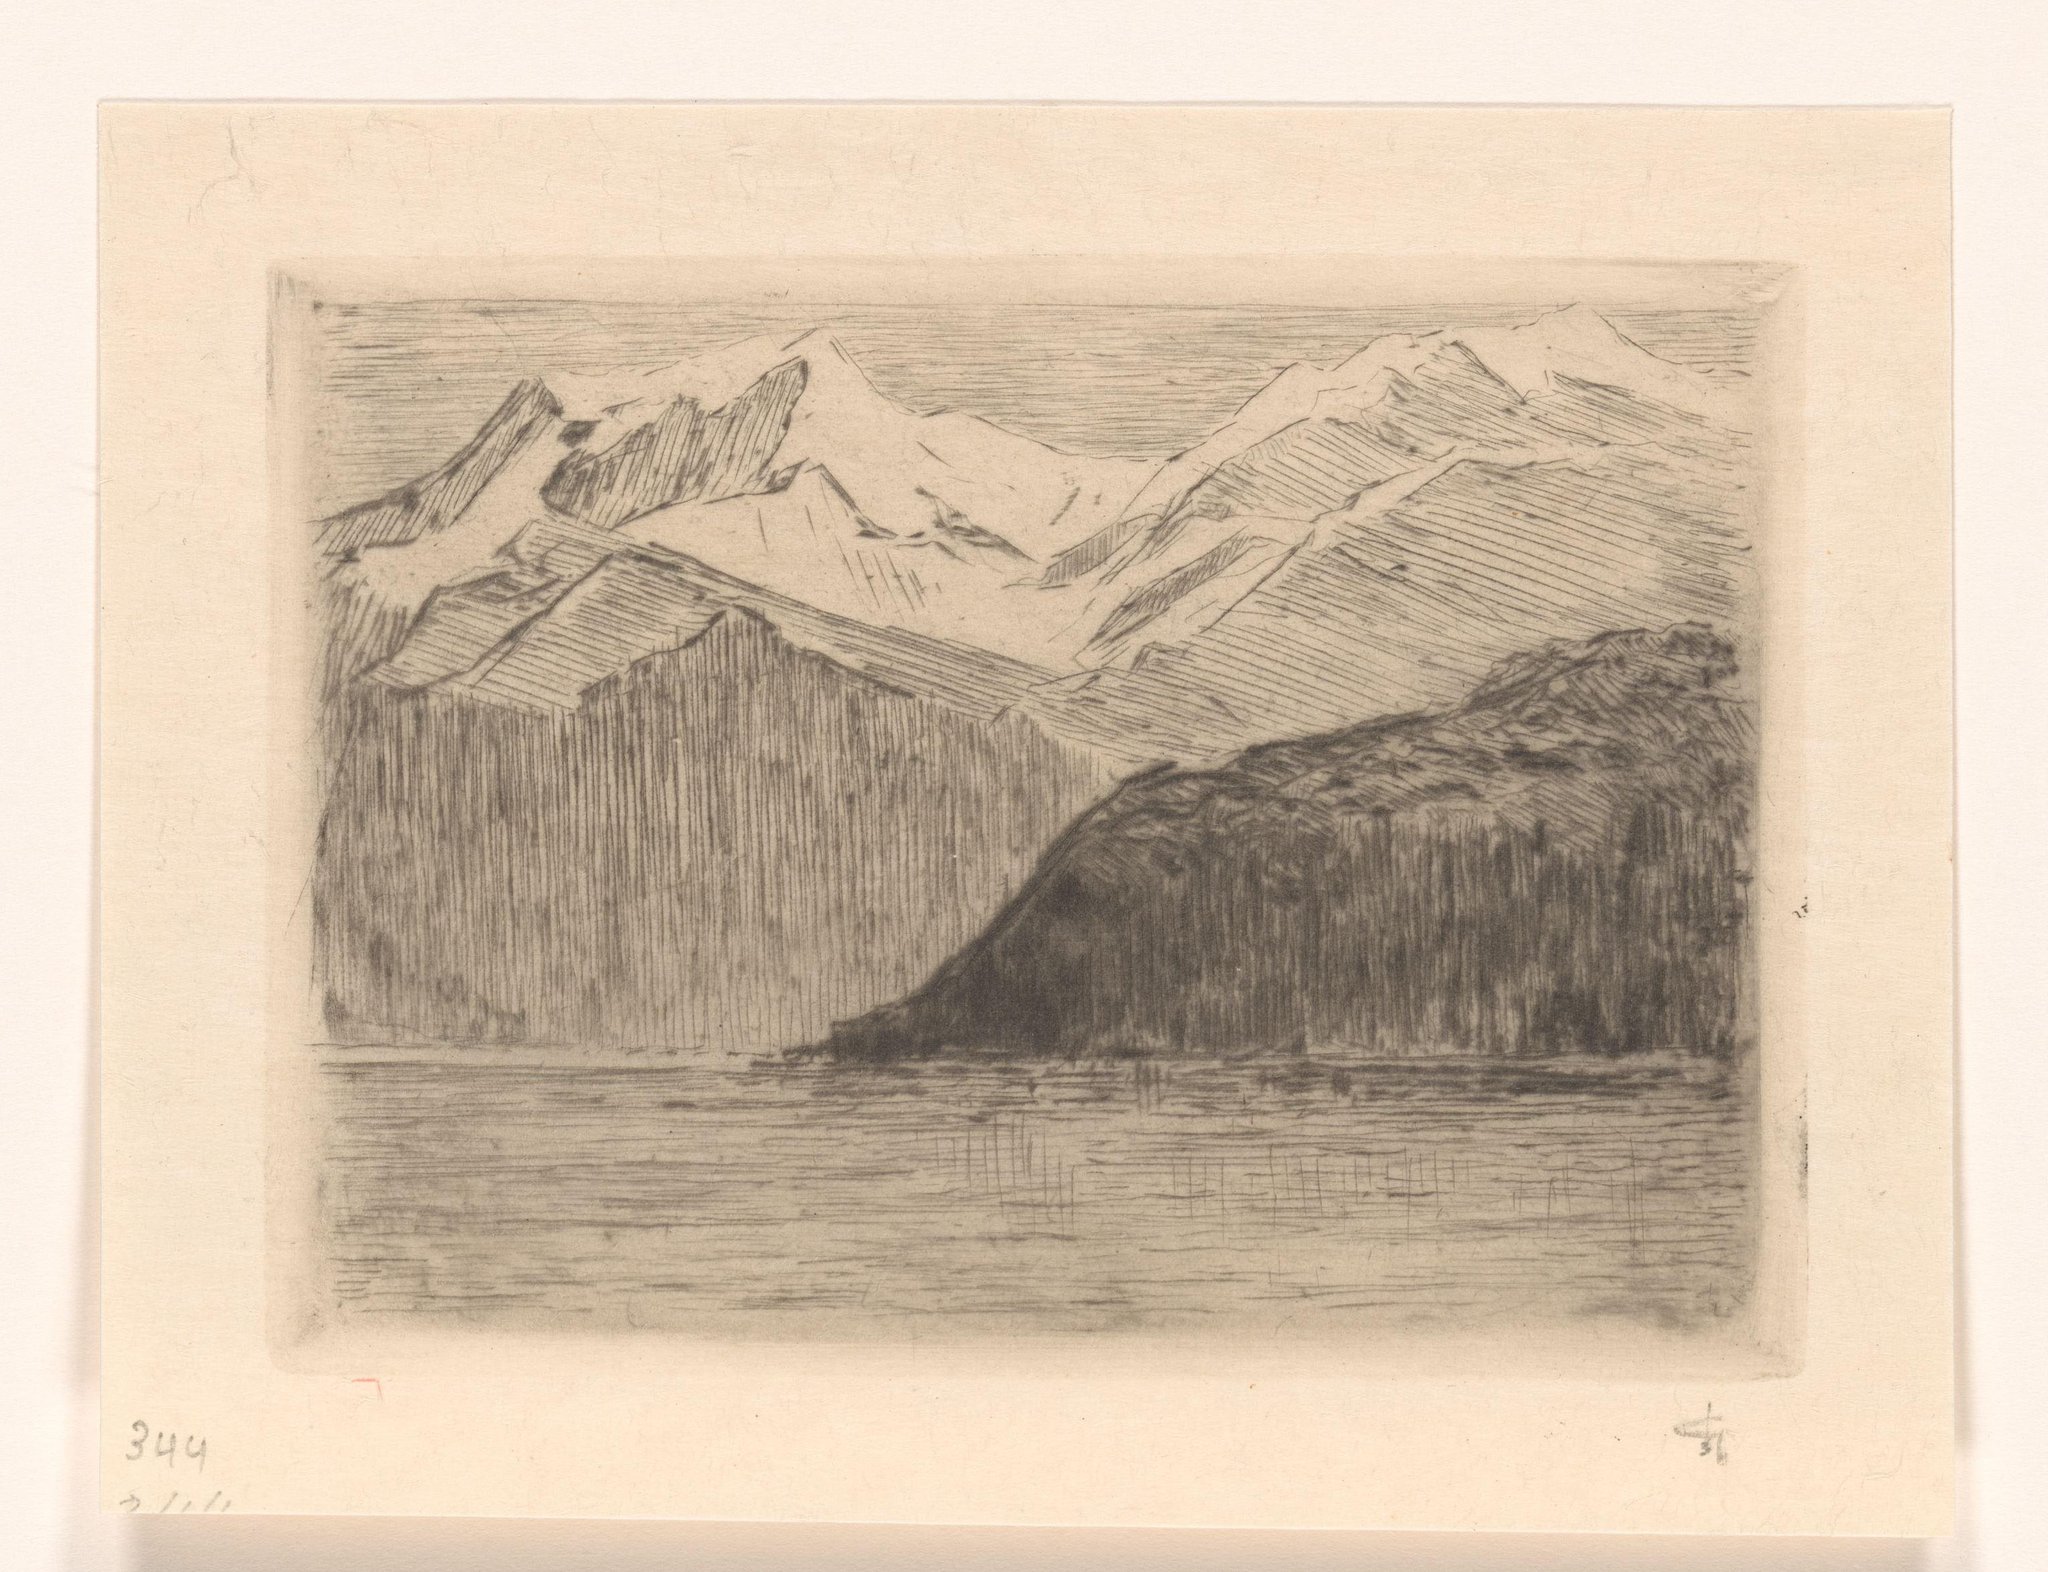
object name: print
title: Gezicht op Urisee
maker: carel nicolaas storm van s-gravesande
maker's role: draughtsman, print maker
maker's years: 1841-1924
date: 1889-1902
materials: paper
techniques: drypoint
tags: lake, mountain-range, snow peaks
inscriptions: number: ‘344’, collector's mark: Lugt 2228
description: Mogelijk vermeld in: Storm van 's-Gravesande, Charles. Catalogue des eaux-fortes et lithographies. New York: s.n., 1903, of in een onbekende latere uitgave van het manuscript. Vermoedelijk vermeld als catalogusnummer 344.